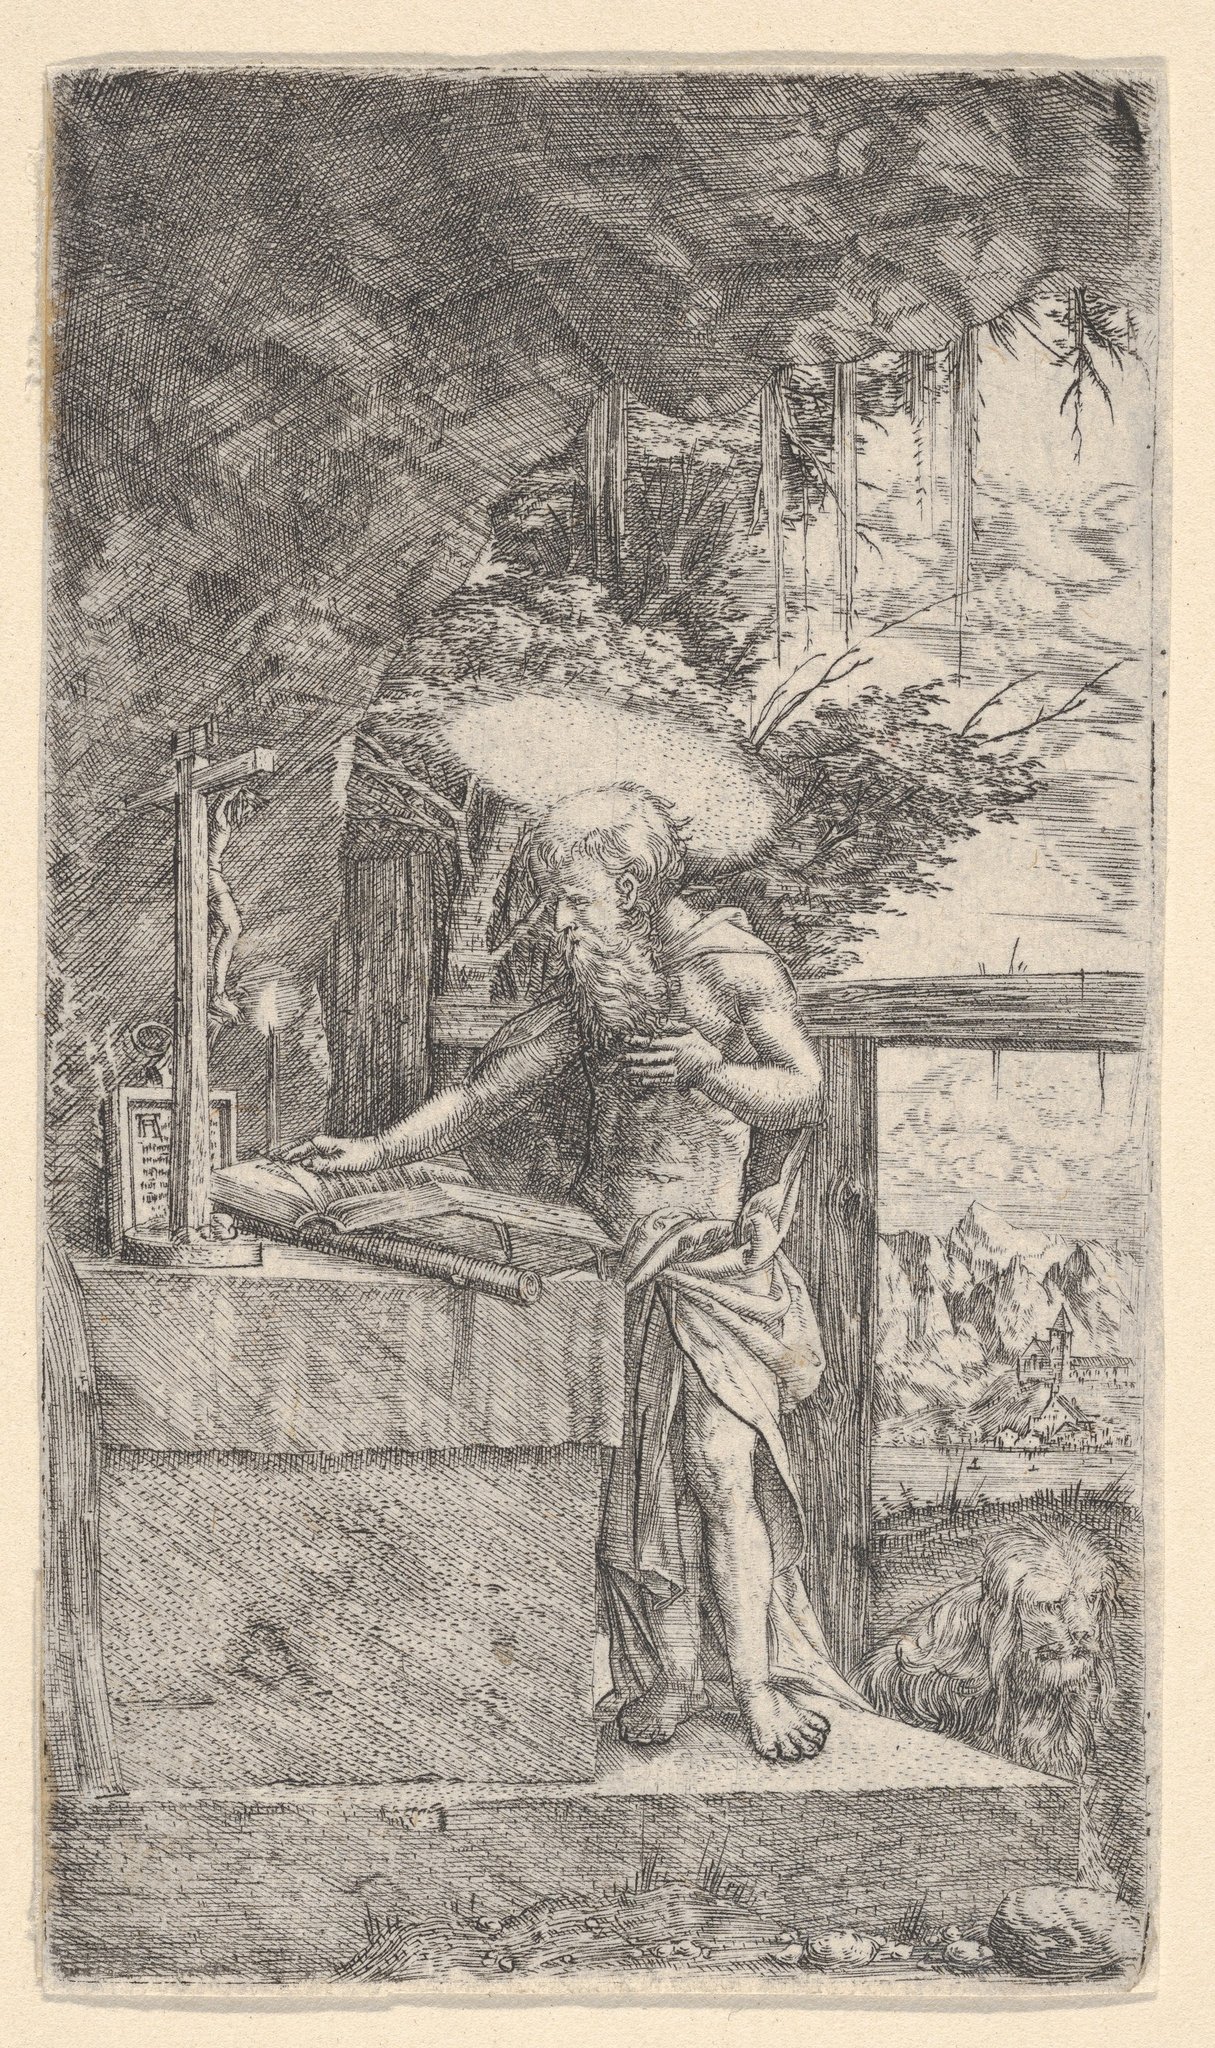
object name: print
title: Saint Jerome Reading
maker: albrecht altdorfer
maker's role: artist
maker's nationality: german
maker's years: 1480-1538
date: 1500-1538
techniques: engraving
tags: books,reading,saint jerome,cross